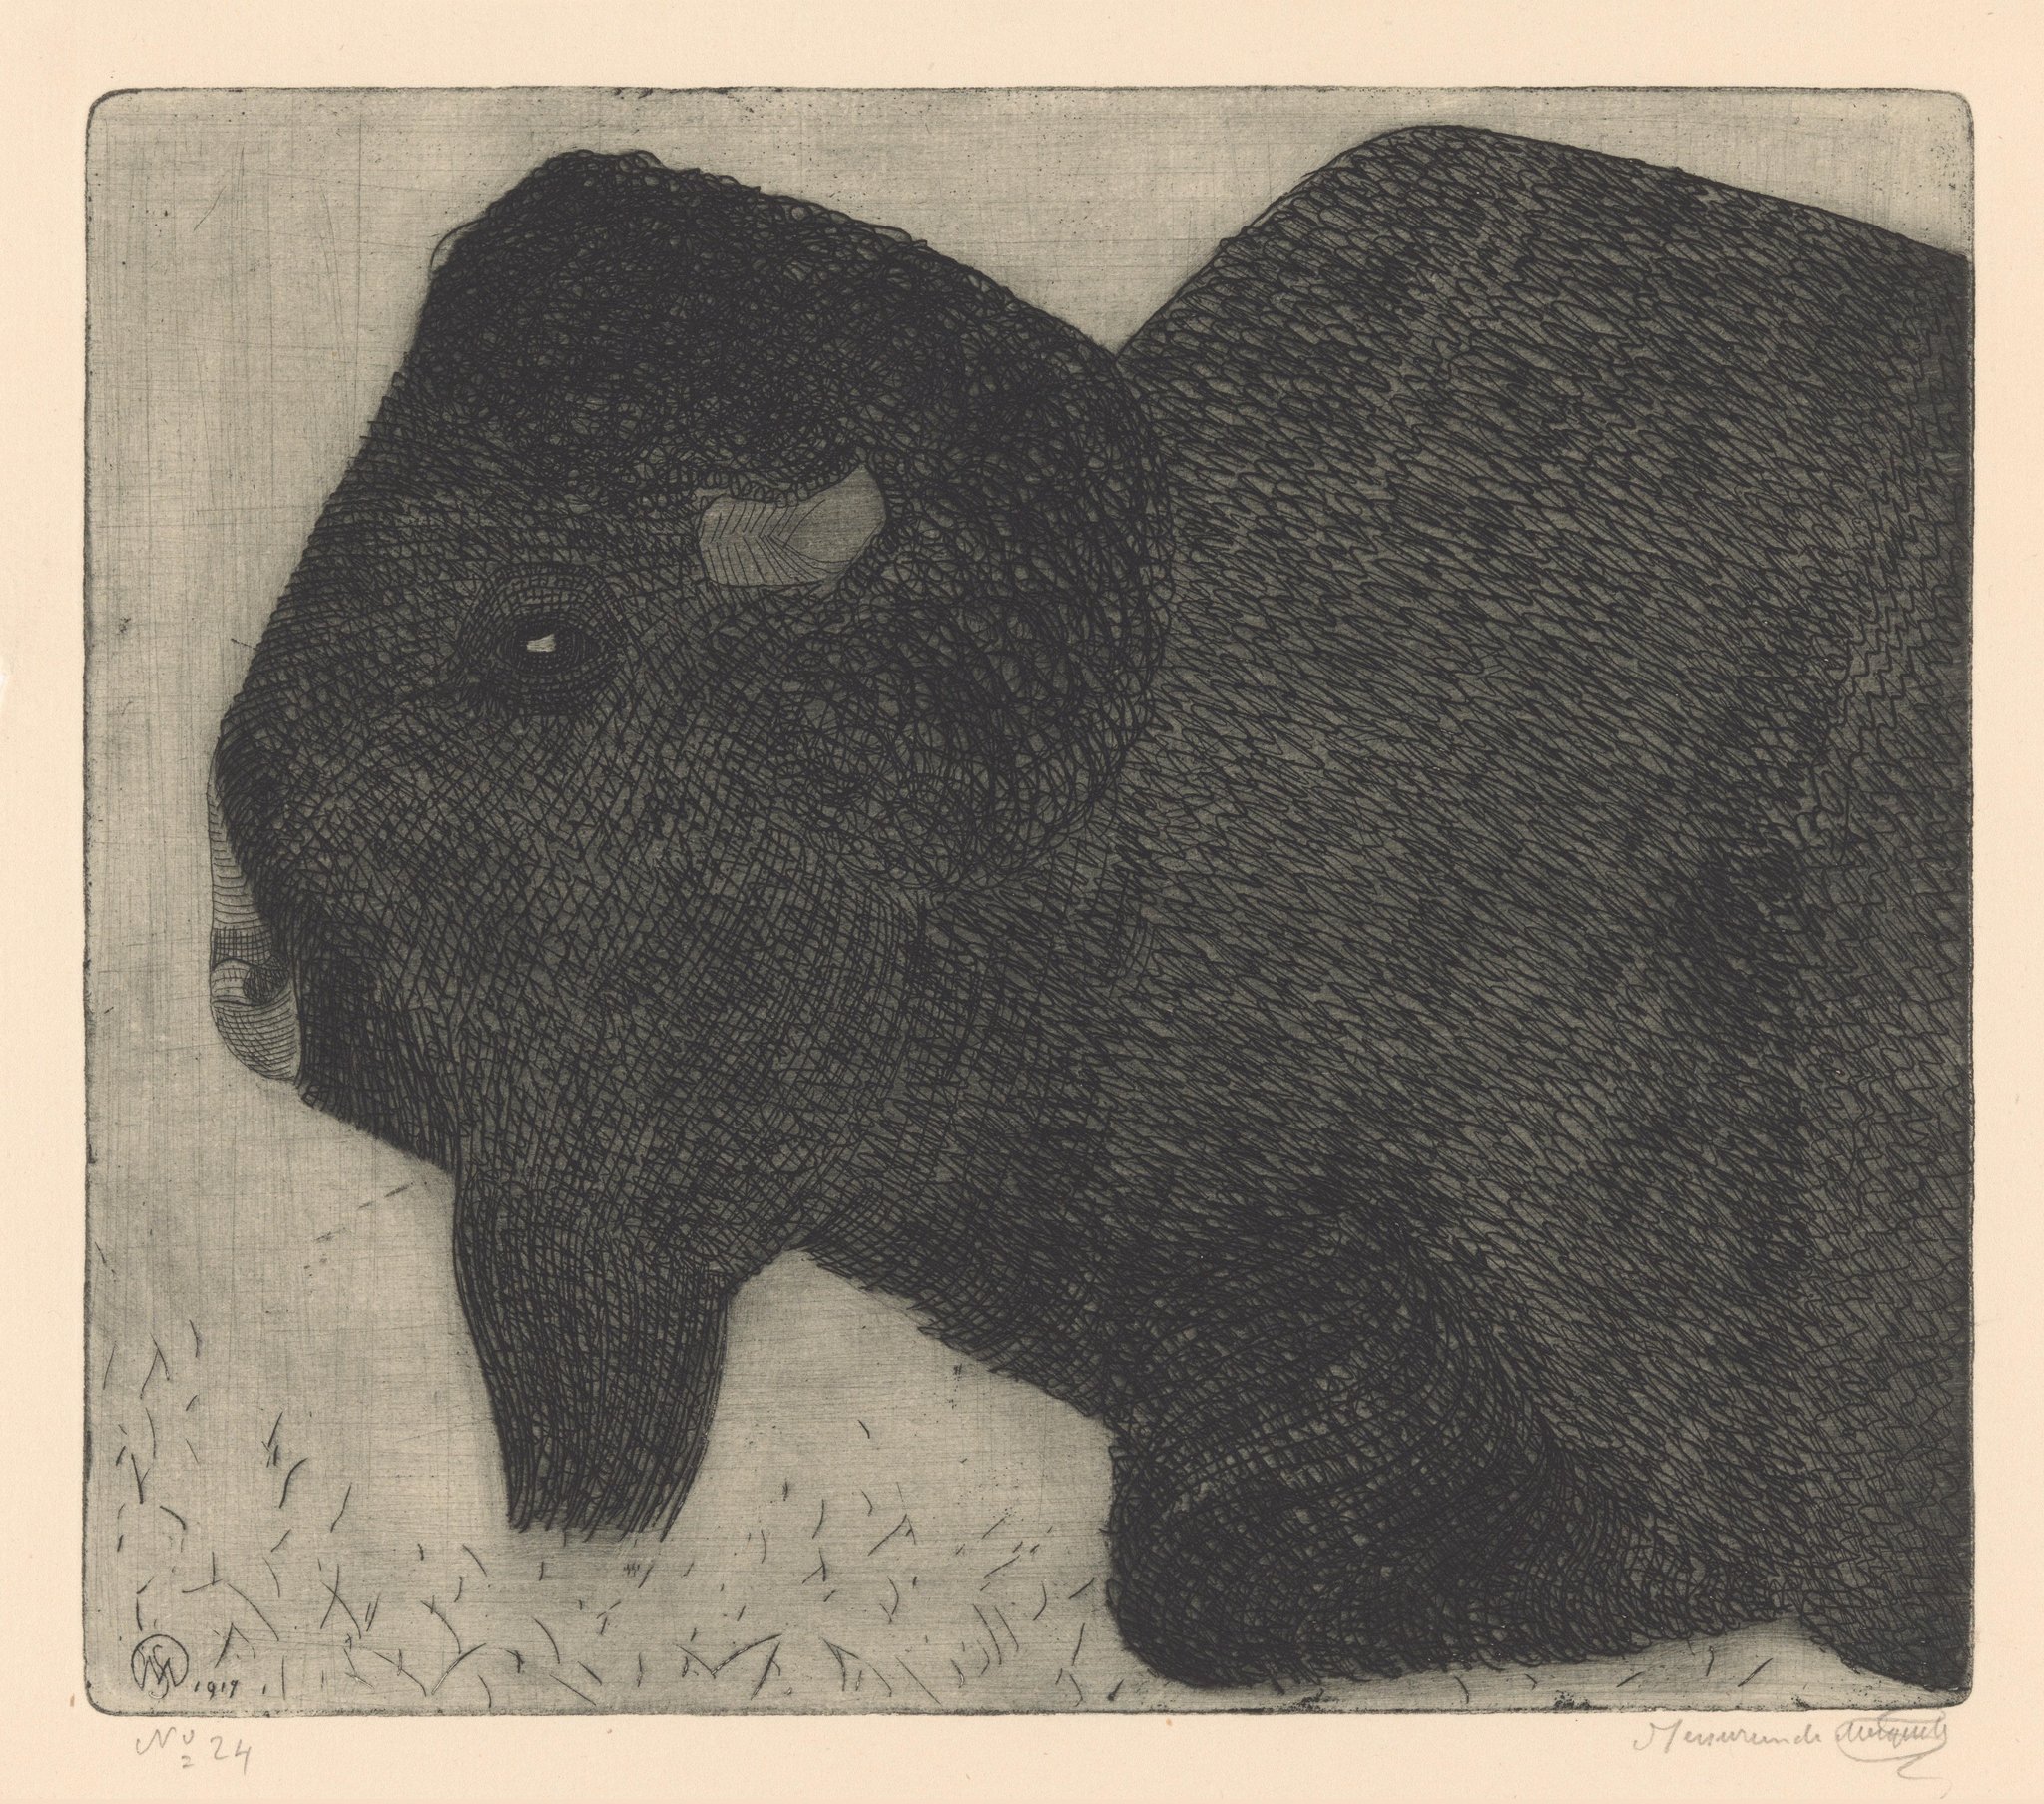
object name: print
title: Bizon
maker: samuel jessurun de mesquita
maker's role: draughtsman, print maker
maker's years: 1868-1944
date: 1917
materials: paper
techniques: etching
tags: hoofed animals: bison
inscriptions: number: ‘No 24’, collector's mark: Lugt 733, collector's mark: Lugt 2228